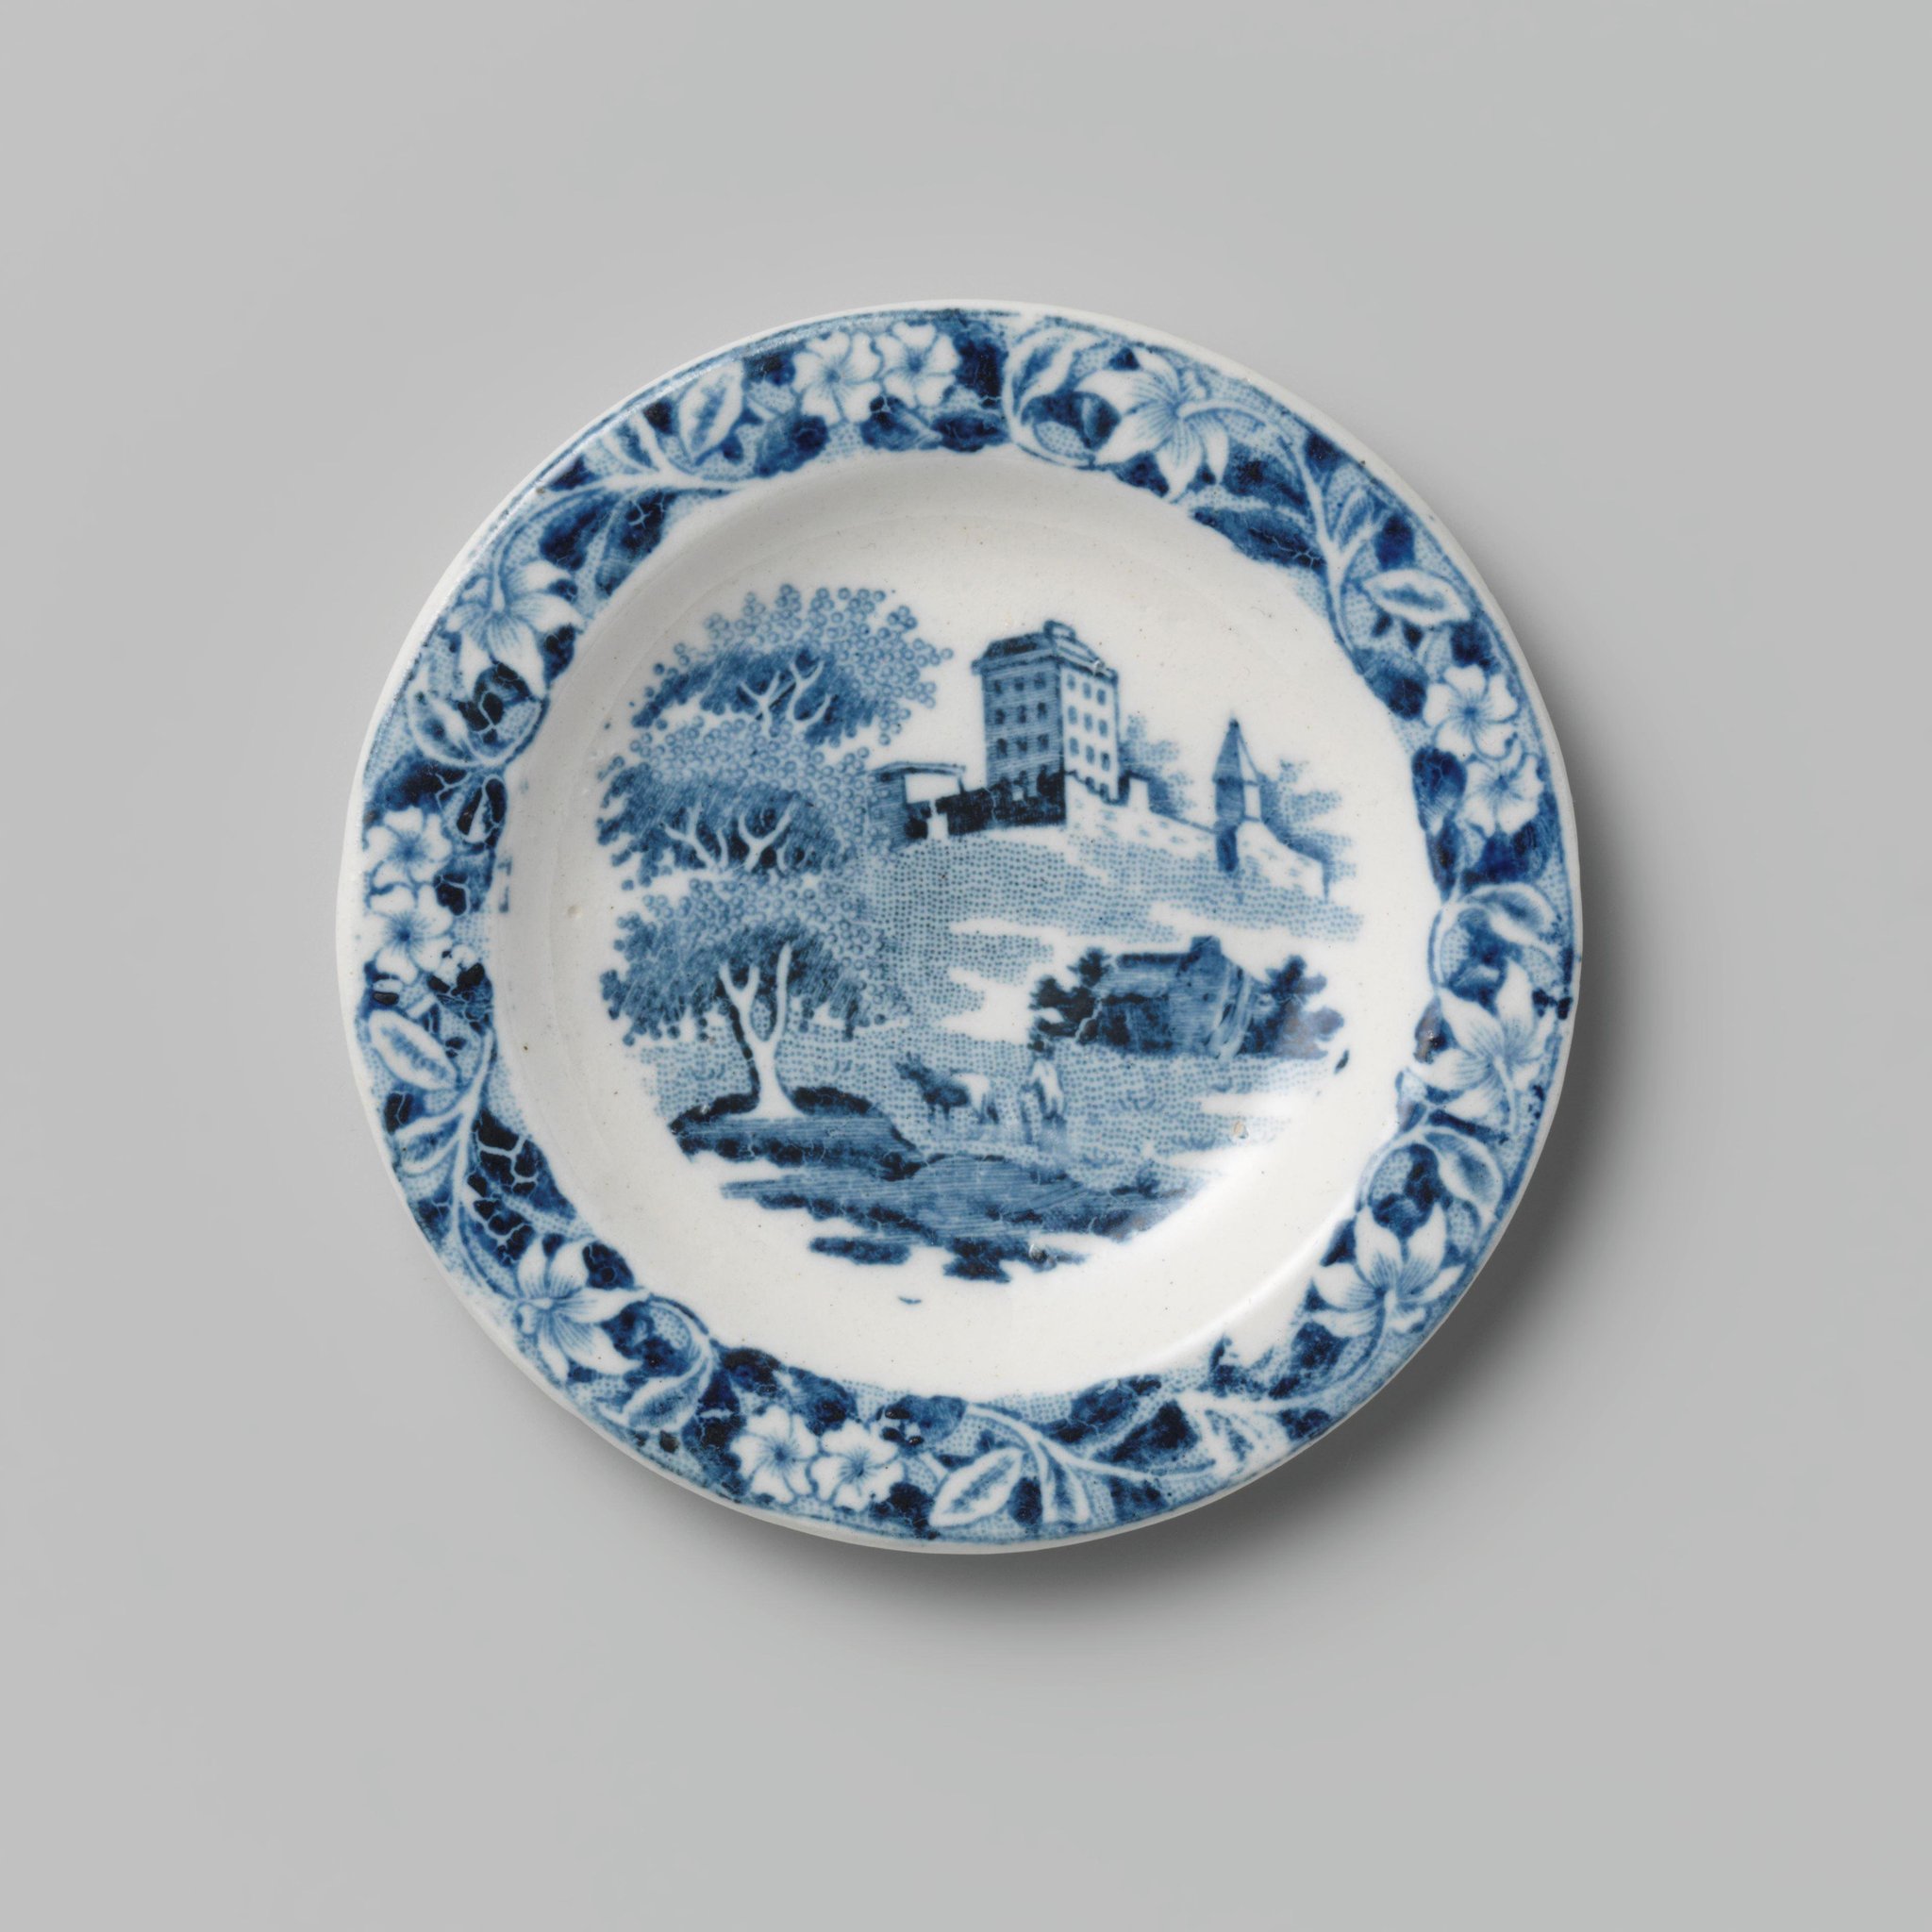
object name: plate dish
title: Rond, plat bord van hardgebakken aardewerk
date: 1840-1860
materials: earthenware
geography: shelton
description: Rond, plat bord van hardgebakken aardewerk met op het plat een decoratie in blauw van een landschap met gebouwen, een boom en een man met een dier. De rand is versierd met bloemtakken. Het bord is gemerkt: Hackwood. Het bord hoort bij drie gelijke borden (BK-NM-14091-A t/m BK-NM-14091-D).